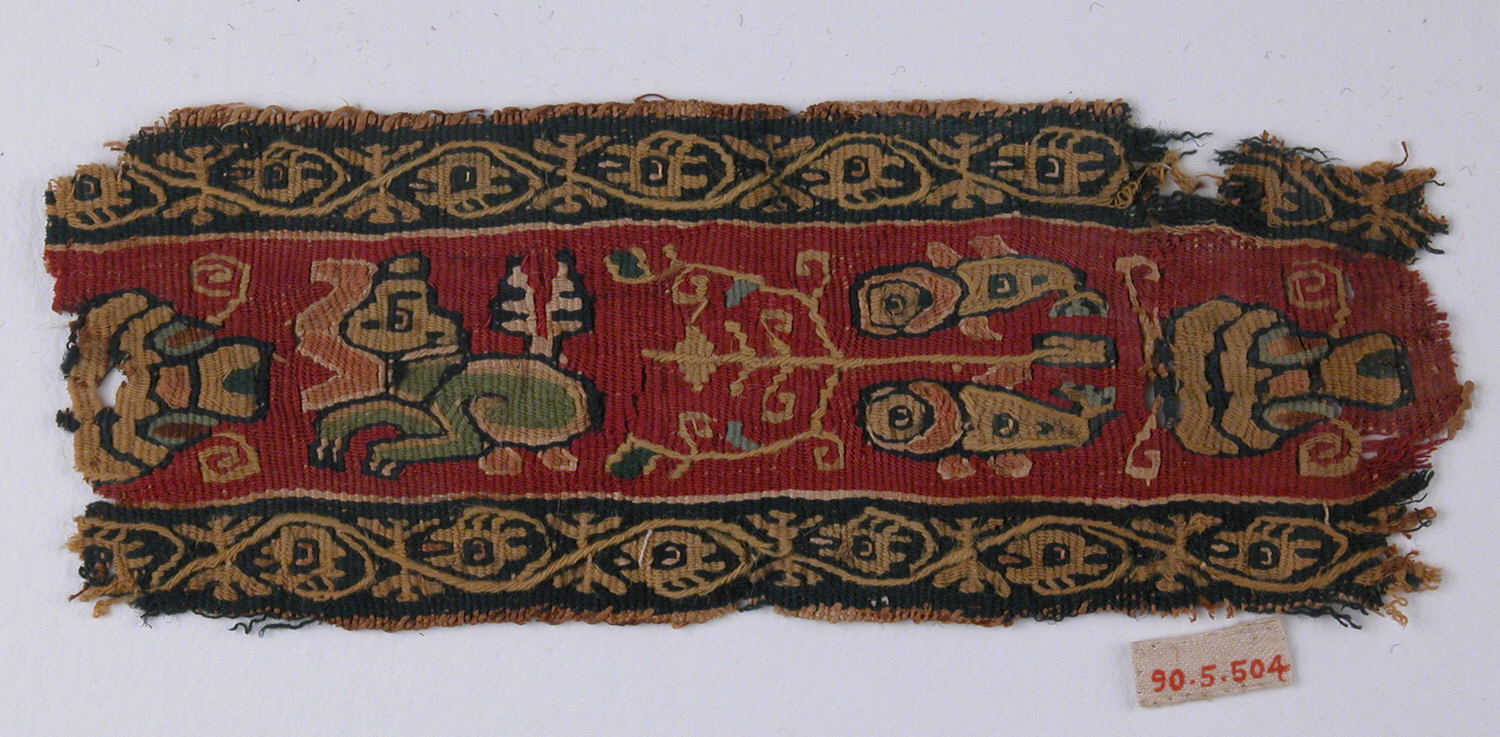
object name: textile fragment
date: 601-800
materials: linen, wool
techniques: weave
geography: egypt